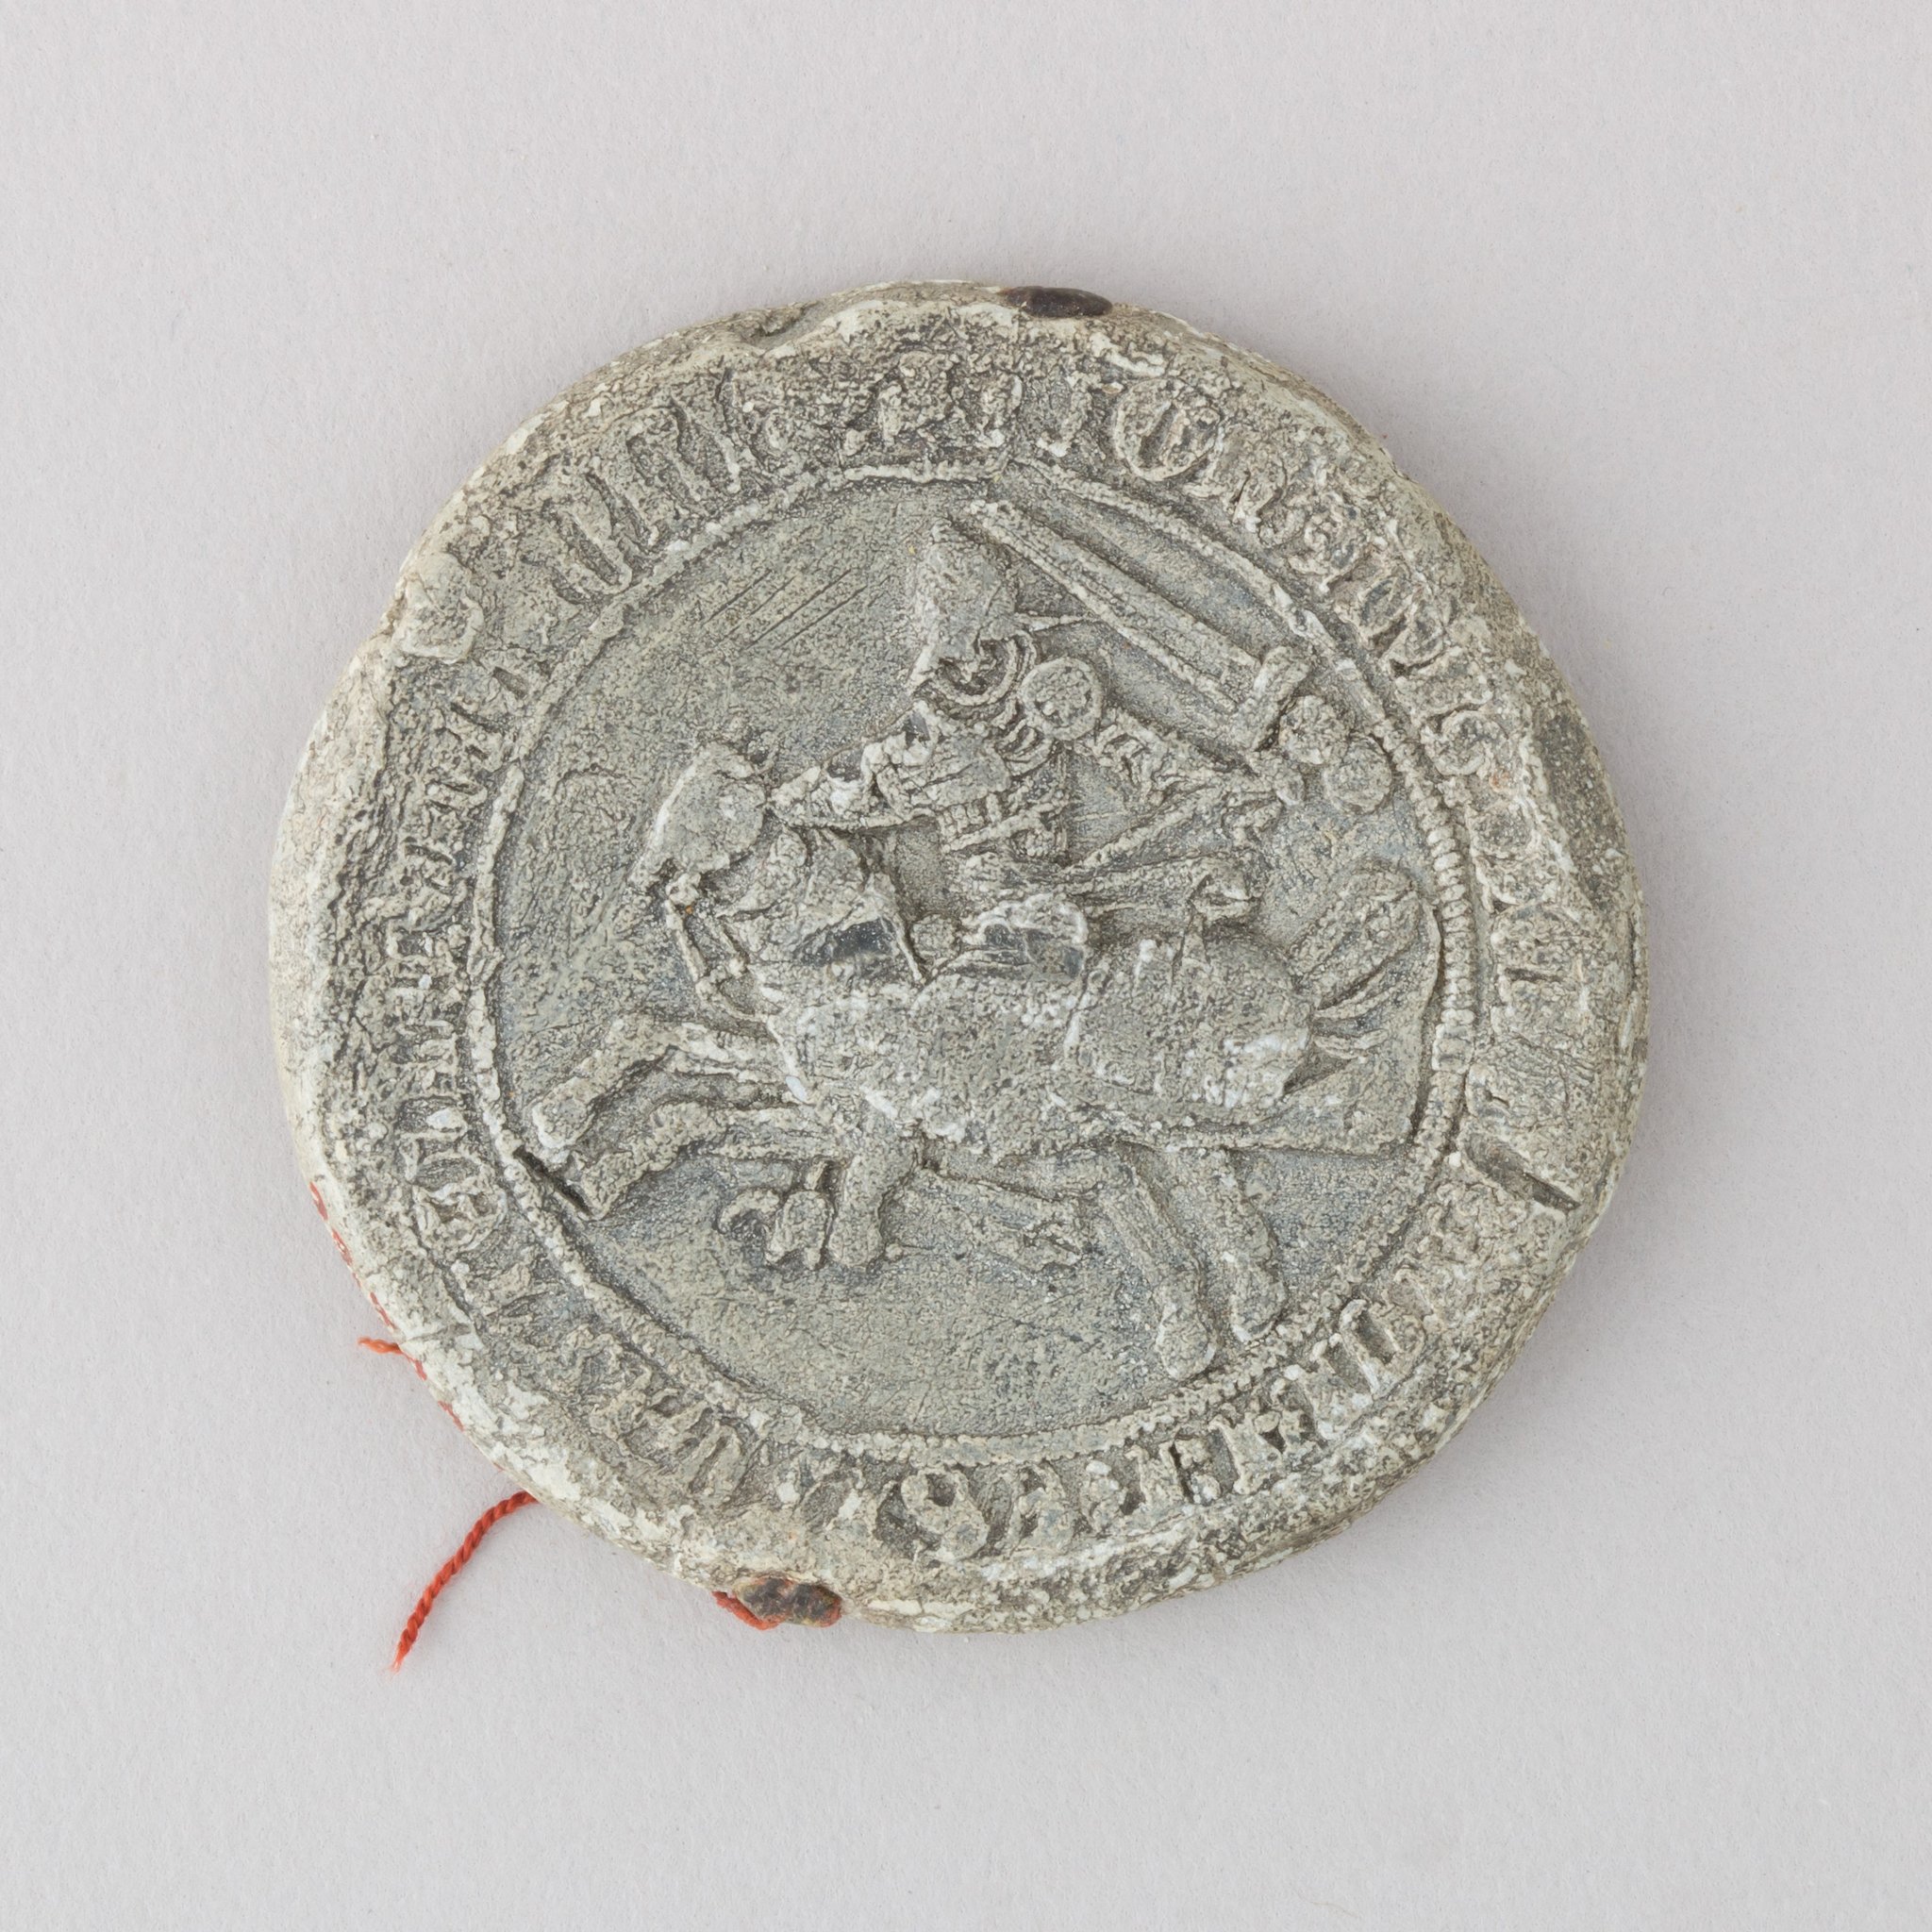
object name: seal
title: Seal of John II, King of Castile and Leon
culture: spanish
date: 1401-1500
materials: lead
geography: spain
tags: horses